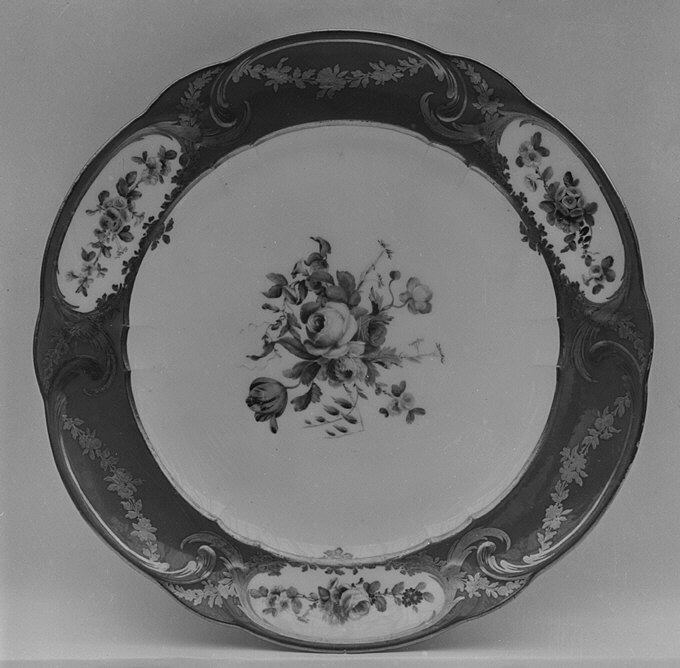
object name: plate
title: Plate (assiette à palmes) (1 of 102) (part of a service)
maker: sèvres manufactory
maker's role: manufactory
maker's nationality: french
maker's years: 1740-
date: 1772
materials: soft paste porcelain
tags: flowers